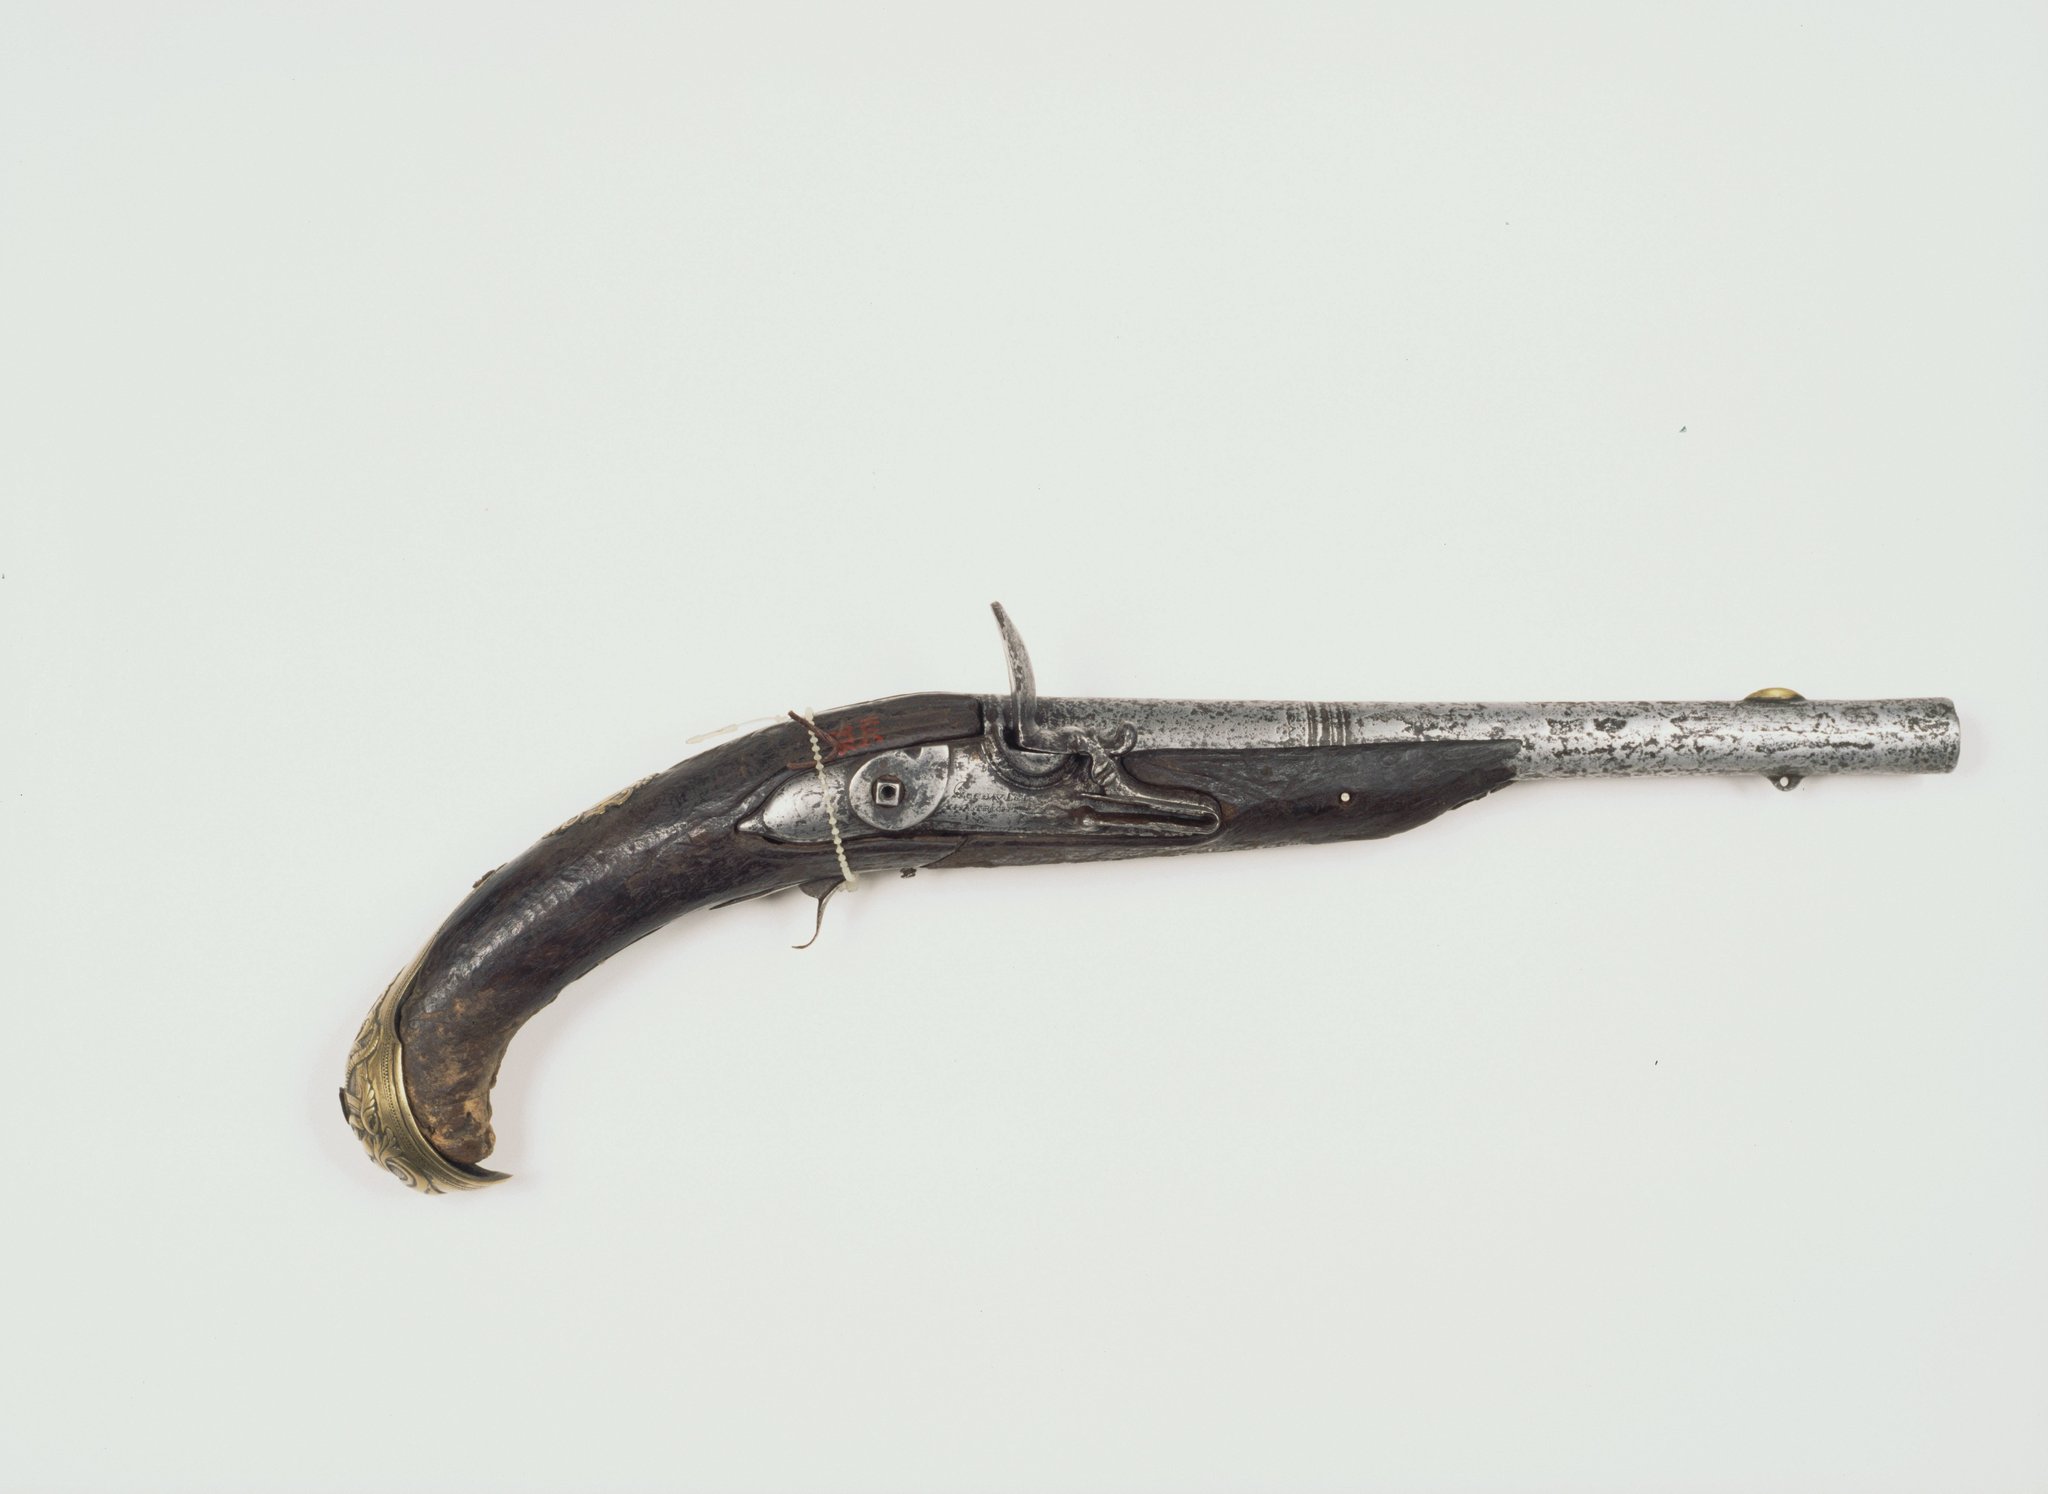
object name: pistol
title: Vuursteen pistool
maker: godefroi corbeau (ii)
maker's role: geweermaker, pistoolmaker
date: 1717-1750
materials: brass, iron, wood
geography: maastricht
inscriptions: : ‘CORBAV LE’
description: Pistool met vuursteenslot, ijzeren ronde gladde loop die wordt onderbroken door een profielband. IJzeren slotplaat waarvan de haan ontbreekt en op de rechterzijde staat de naam "CORBAV LE" (Godfried Corbeau de Jonge) met daaronder "MASTRICHT". De linkerzijde bestaat uit een plaat van messing waarin een monsterkop omgegeven door ranken is gegraveerd. De kolf is van hout en in slechte staat. De kolfkap is van messing waarop een monsterkop met ranken is gemaakt. Aan de bovenzijde is de kolf bewerkt met diverse versieringen. De trekkerbeugel ontbreekt waardoor er twee gleuven zichtbaar zijn naast de ijzeren trekker. Aan het uiteinde van de loop een messing vizierkorrel.